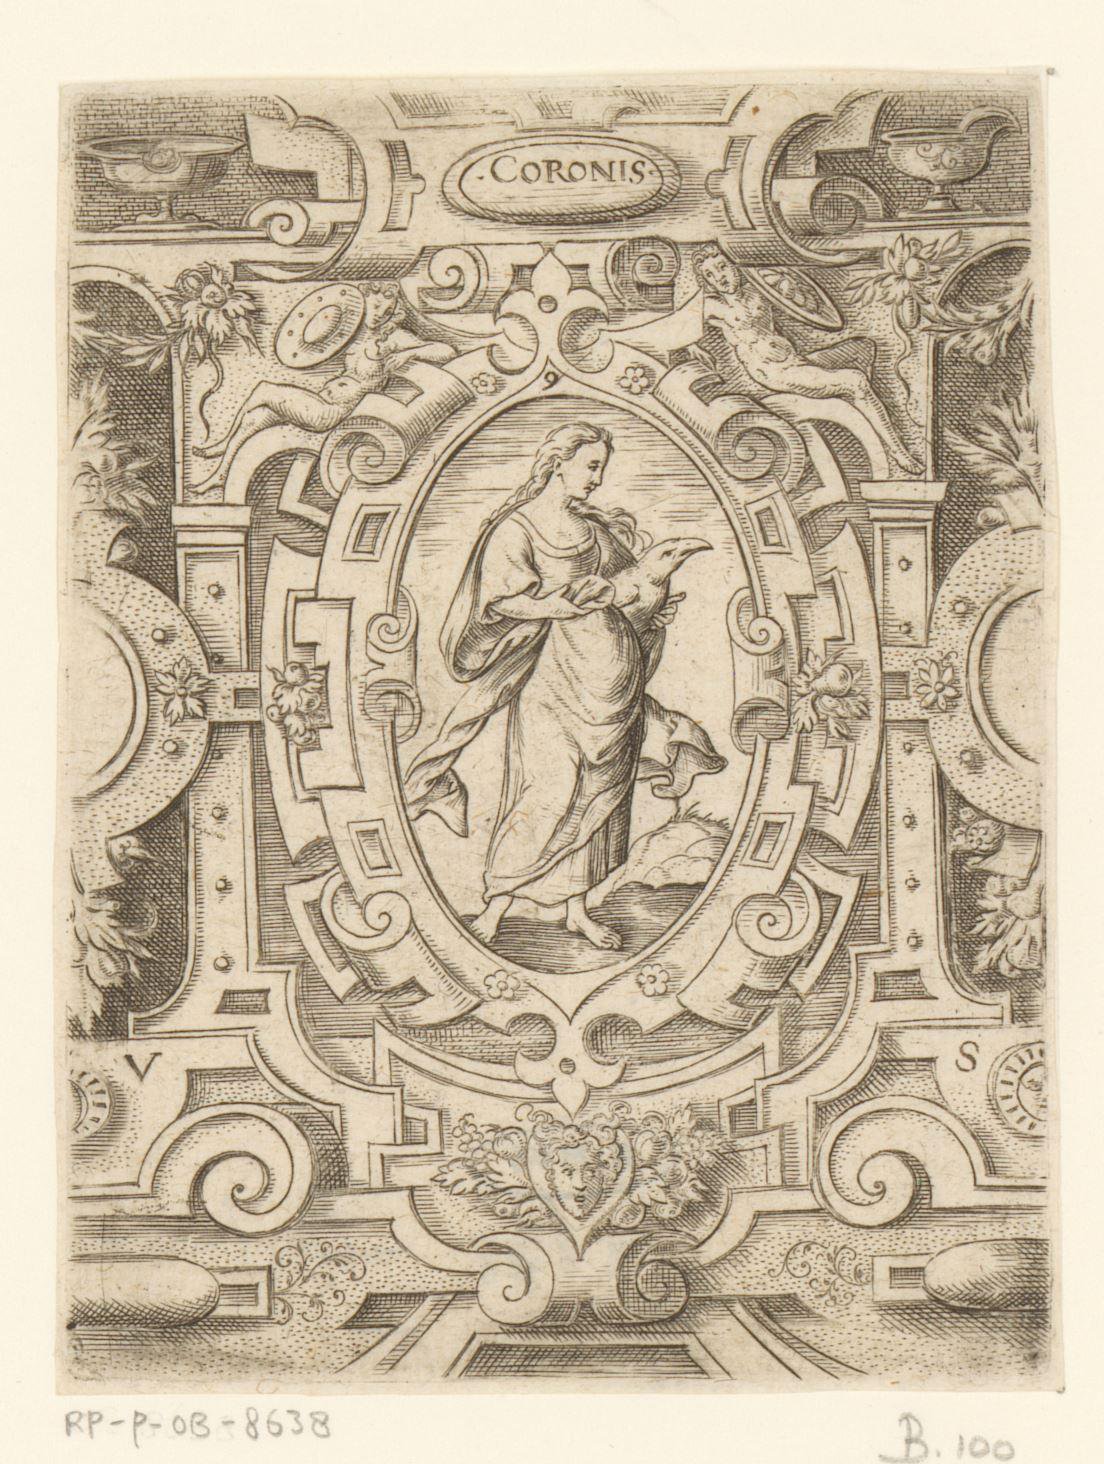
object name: print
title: Coronis in een rolwerk omlijsting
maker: virgilius solis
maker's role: draughtsman, print maker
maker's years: 1514-1562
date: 1524-1562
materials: paper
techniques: engraving, etching, intaglio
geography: nuremberg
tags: scrollwork, strapwork ~ ornament, coronis changed into a crow: to escape the love of neptune, coronis, daughter of coroneus, is changed into a crow by minerva (ovid, metamorphoses ii 569)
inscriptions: collector's mark: Lugt 2228, number: ‘123’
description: Maakt deel uit van een serie van twaalf prenten met vrouwelijke mythologische figuren staand in rolwerk omlijstingen.